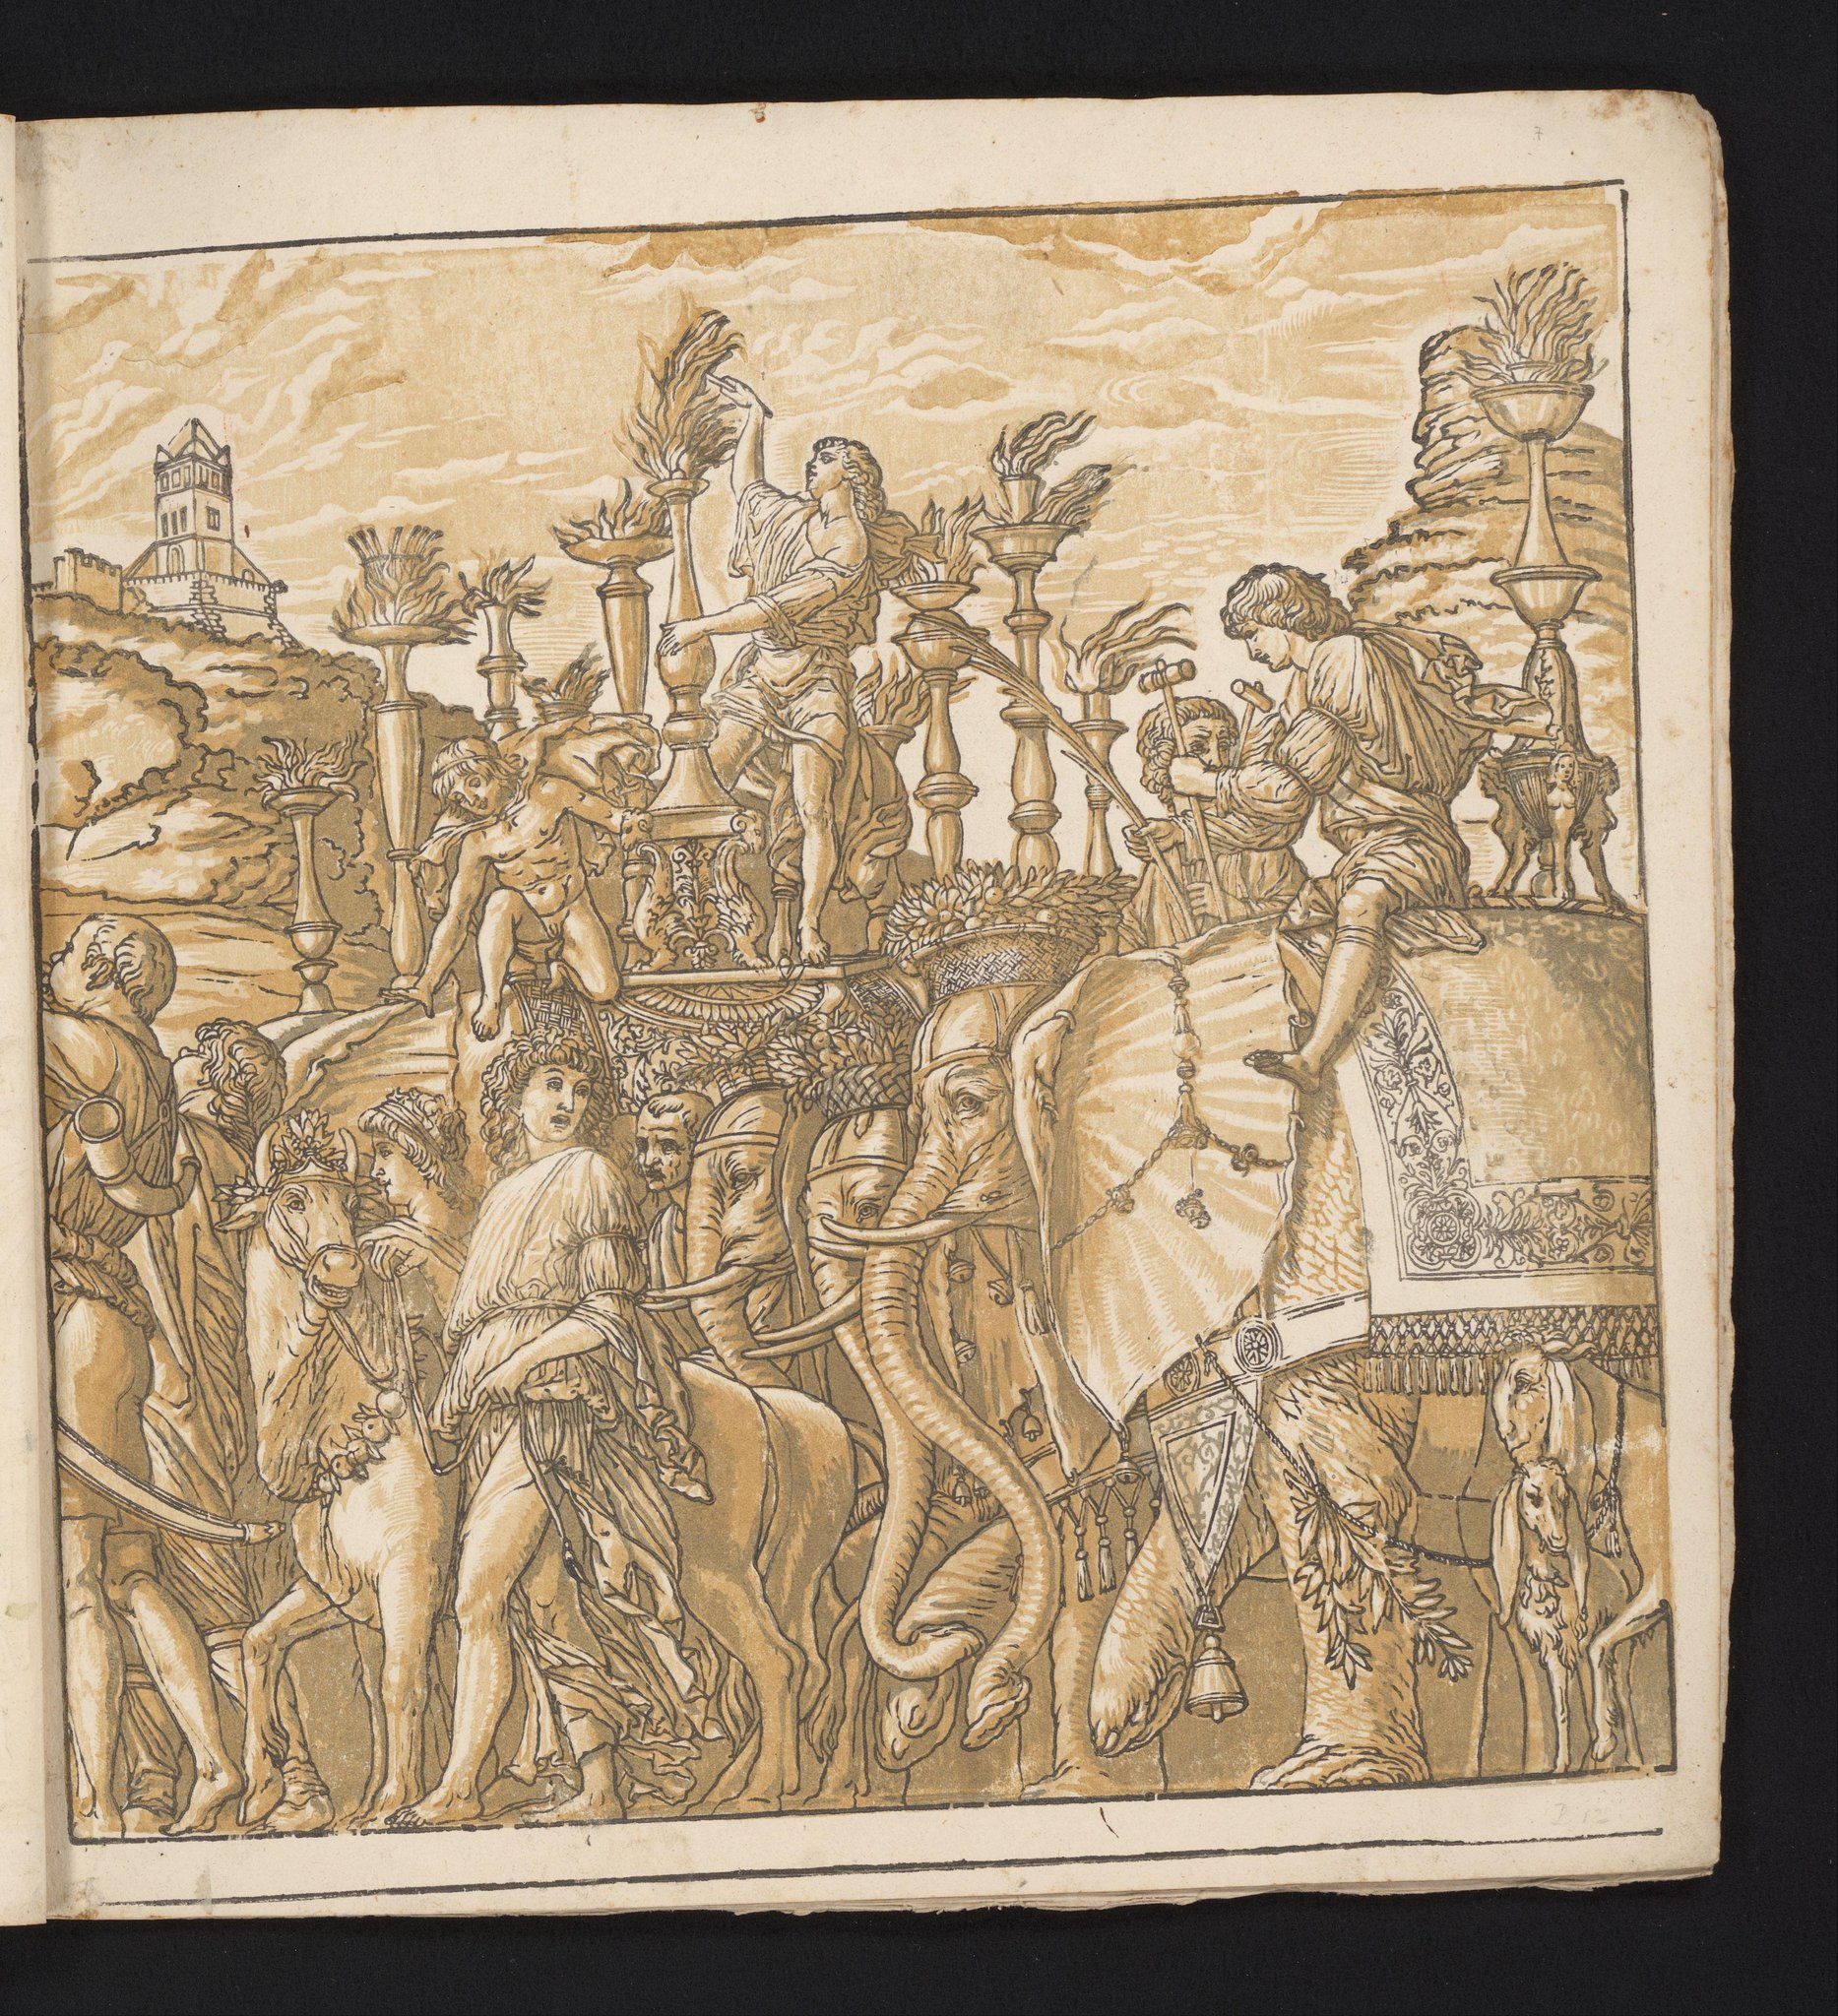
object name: album leaf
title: Triomftocht van Julius Caesar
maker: andrea andreani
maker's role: print maker, printer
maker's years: 1558-1629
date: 1599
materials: paper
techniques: woodcut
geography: mantua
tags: torch, triumph of caesar, trunked animals: elephant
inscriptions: number: ‘5’